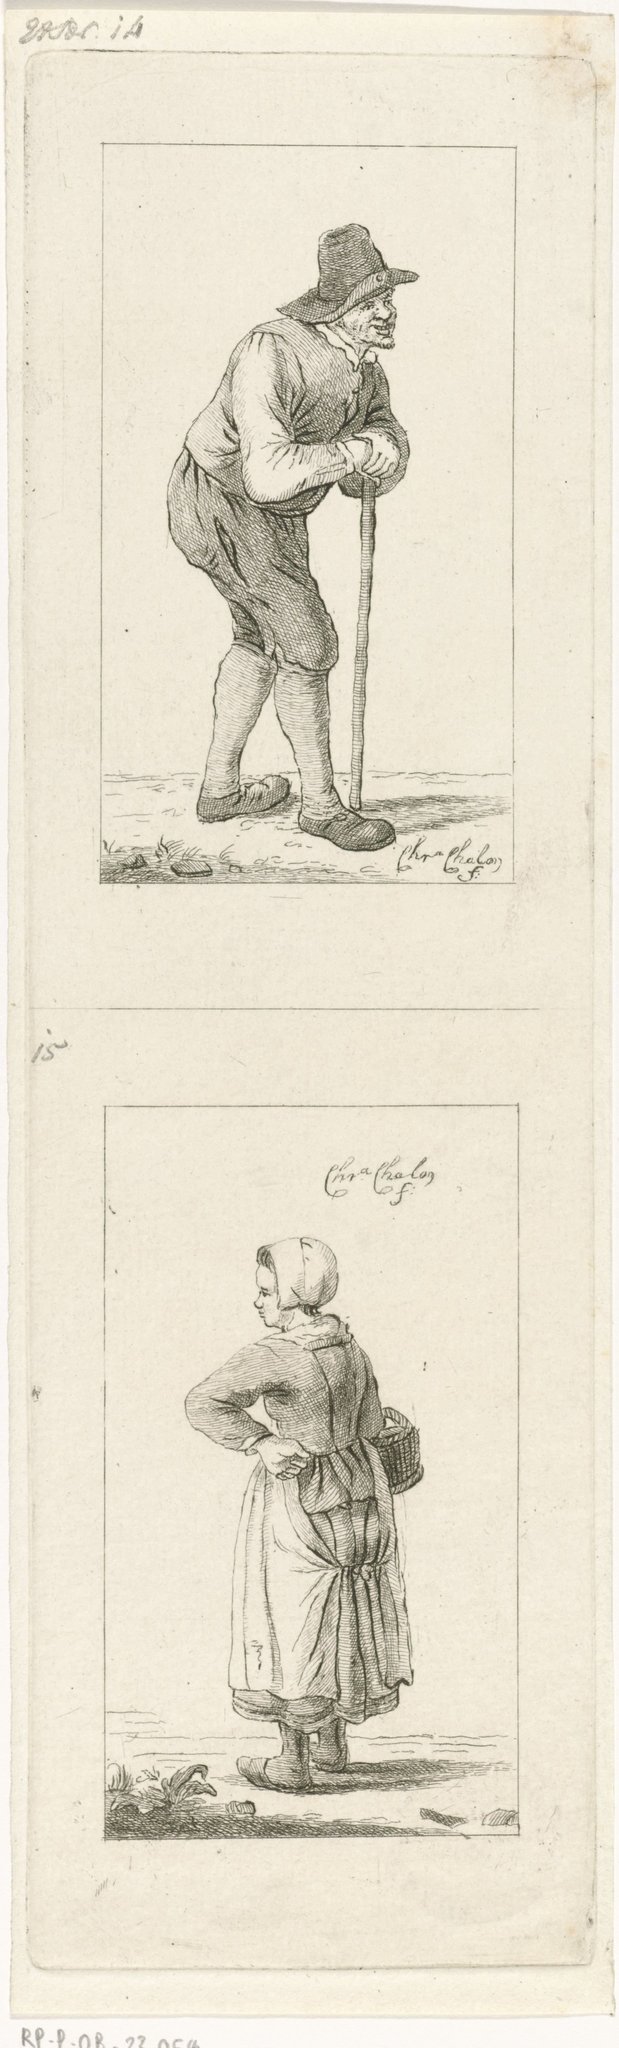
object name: print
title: Man leunend op stok en vrouw met mand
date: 1779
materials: paper, pencil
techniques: etching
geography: leiden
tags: standing figure, leaning figure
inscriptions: collector's mark: Lugt 240, number: ‘Etsdr. 14. 15.’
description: Twee voorstellingen: boven een man met een hoed leunende op zijn stok en onder een vrouw met een mand, een arm in haar zij.